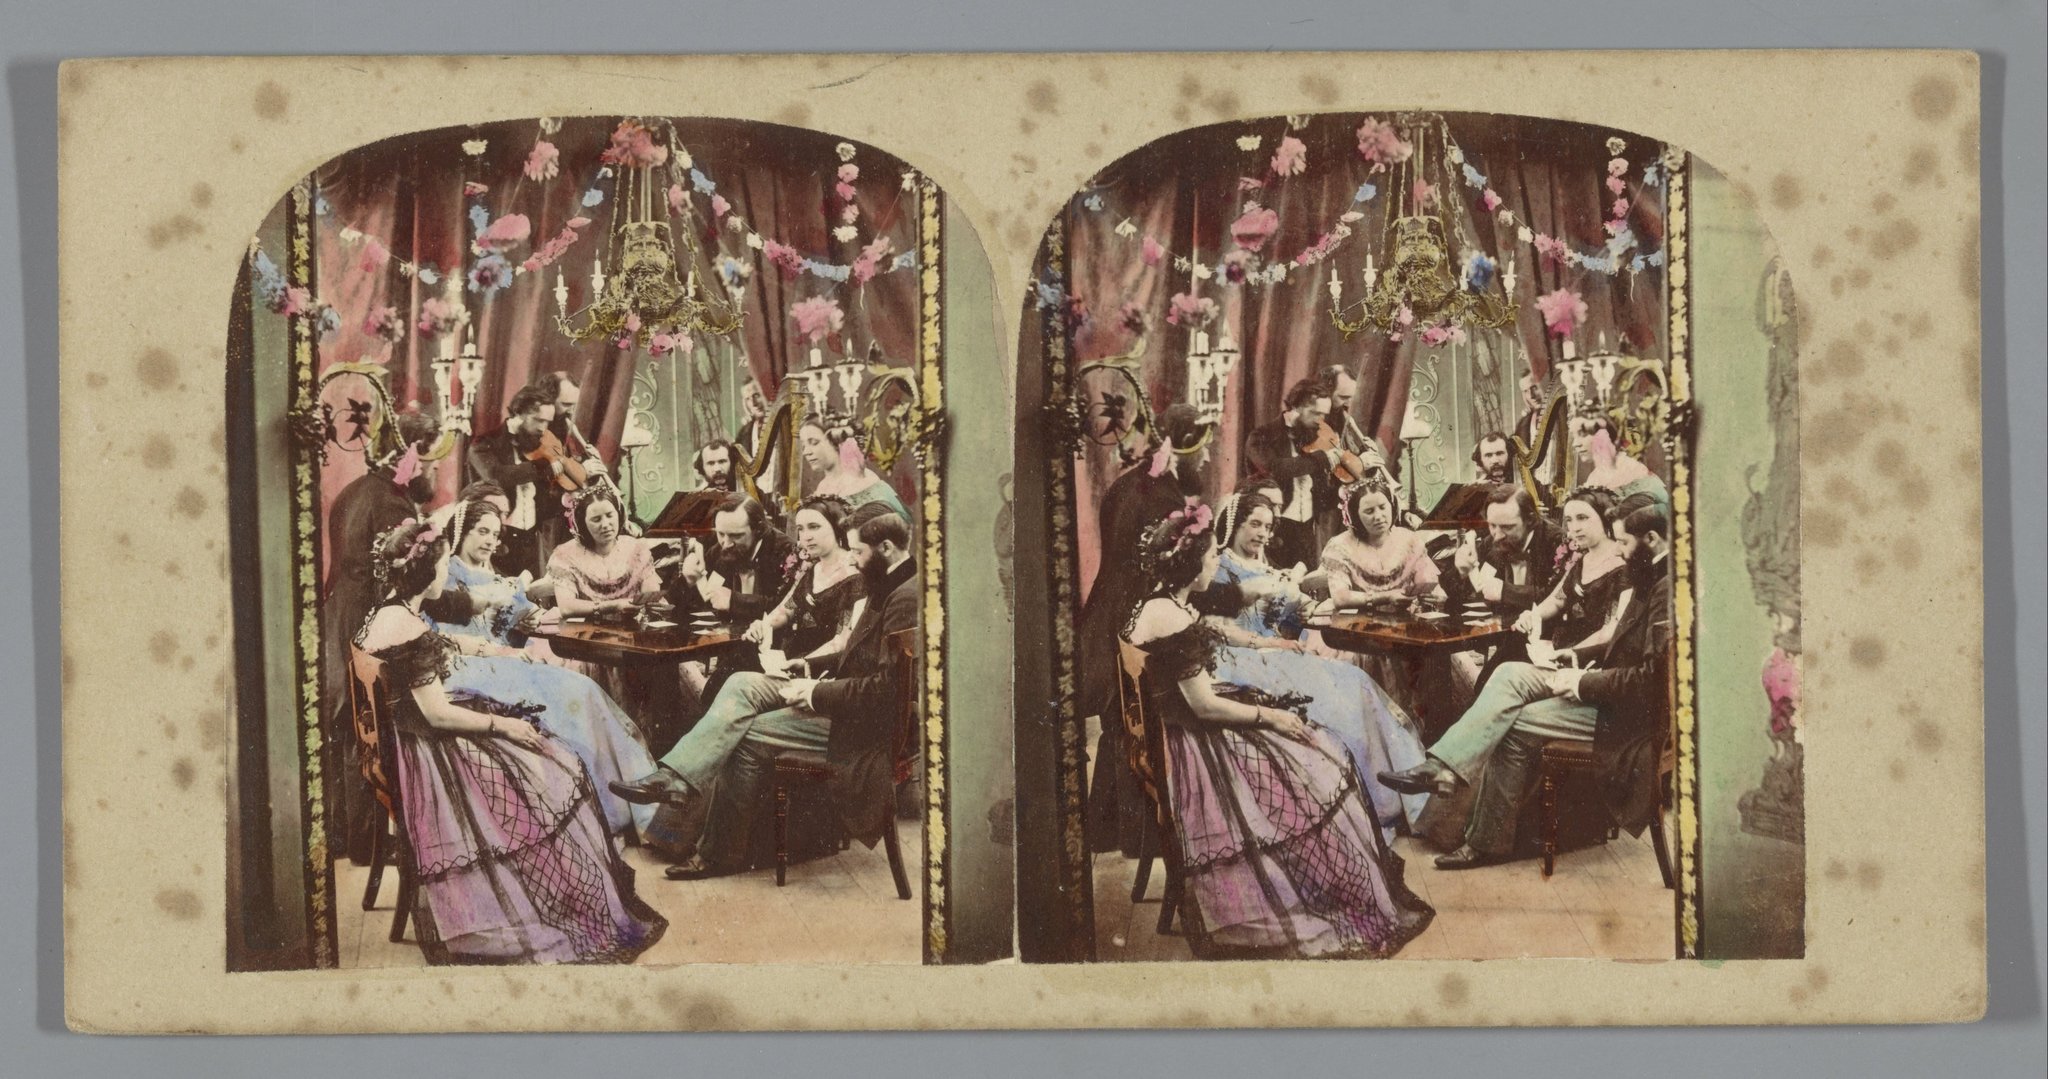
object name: stereograph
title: Kaartenspelend gezelschap en muzikanten in een salon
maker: Anonymous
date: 1852-1863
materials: cardboard, paper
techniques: albumen print, hand coloring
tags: drawing-room, 'salon', playing-cards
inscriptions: inscription: ‘[...]’